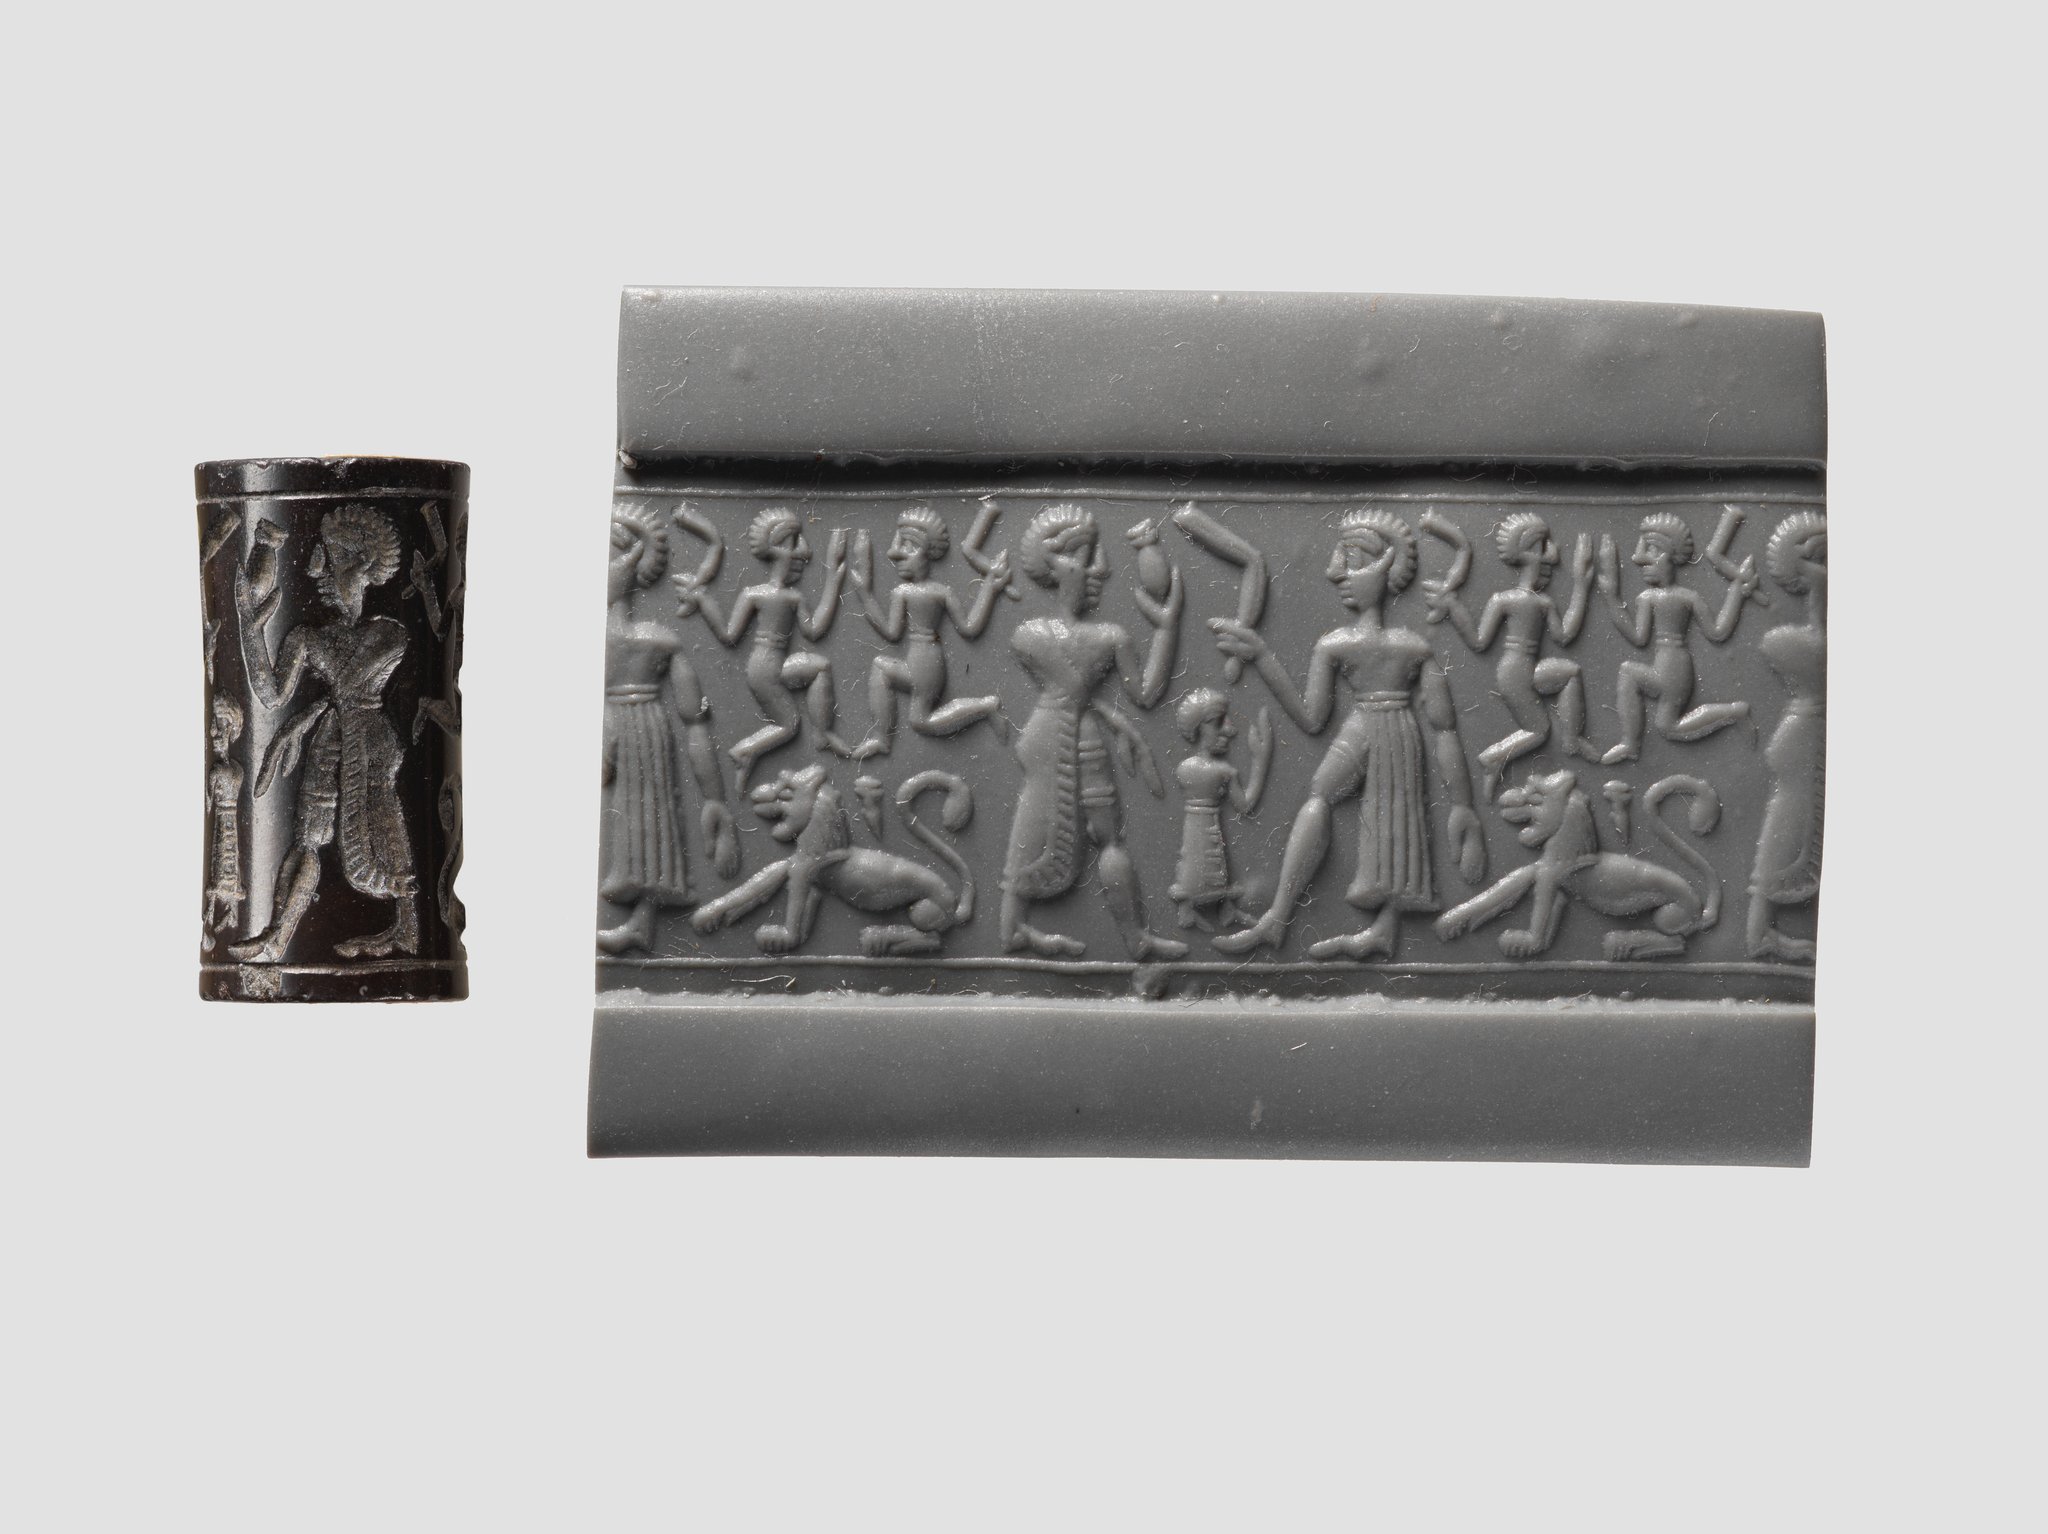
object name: cylinder seal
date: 1820-1730 BCE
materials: mineral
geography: syria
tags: lions